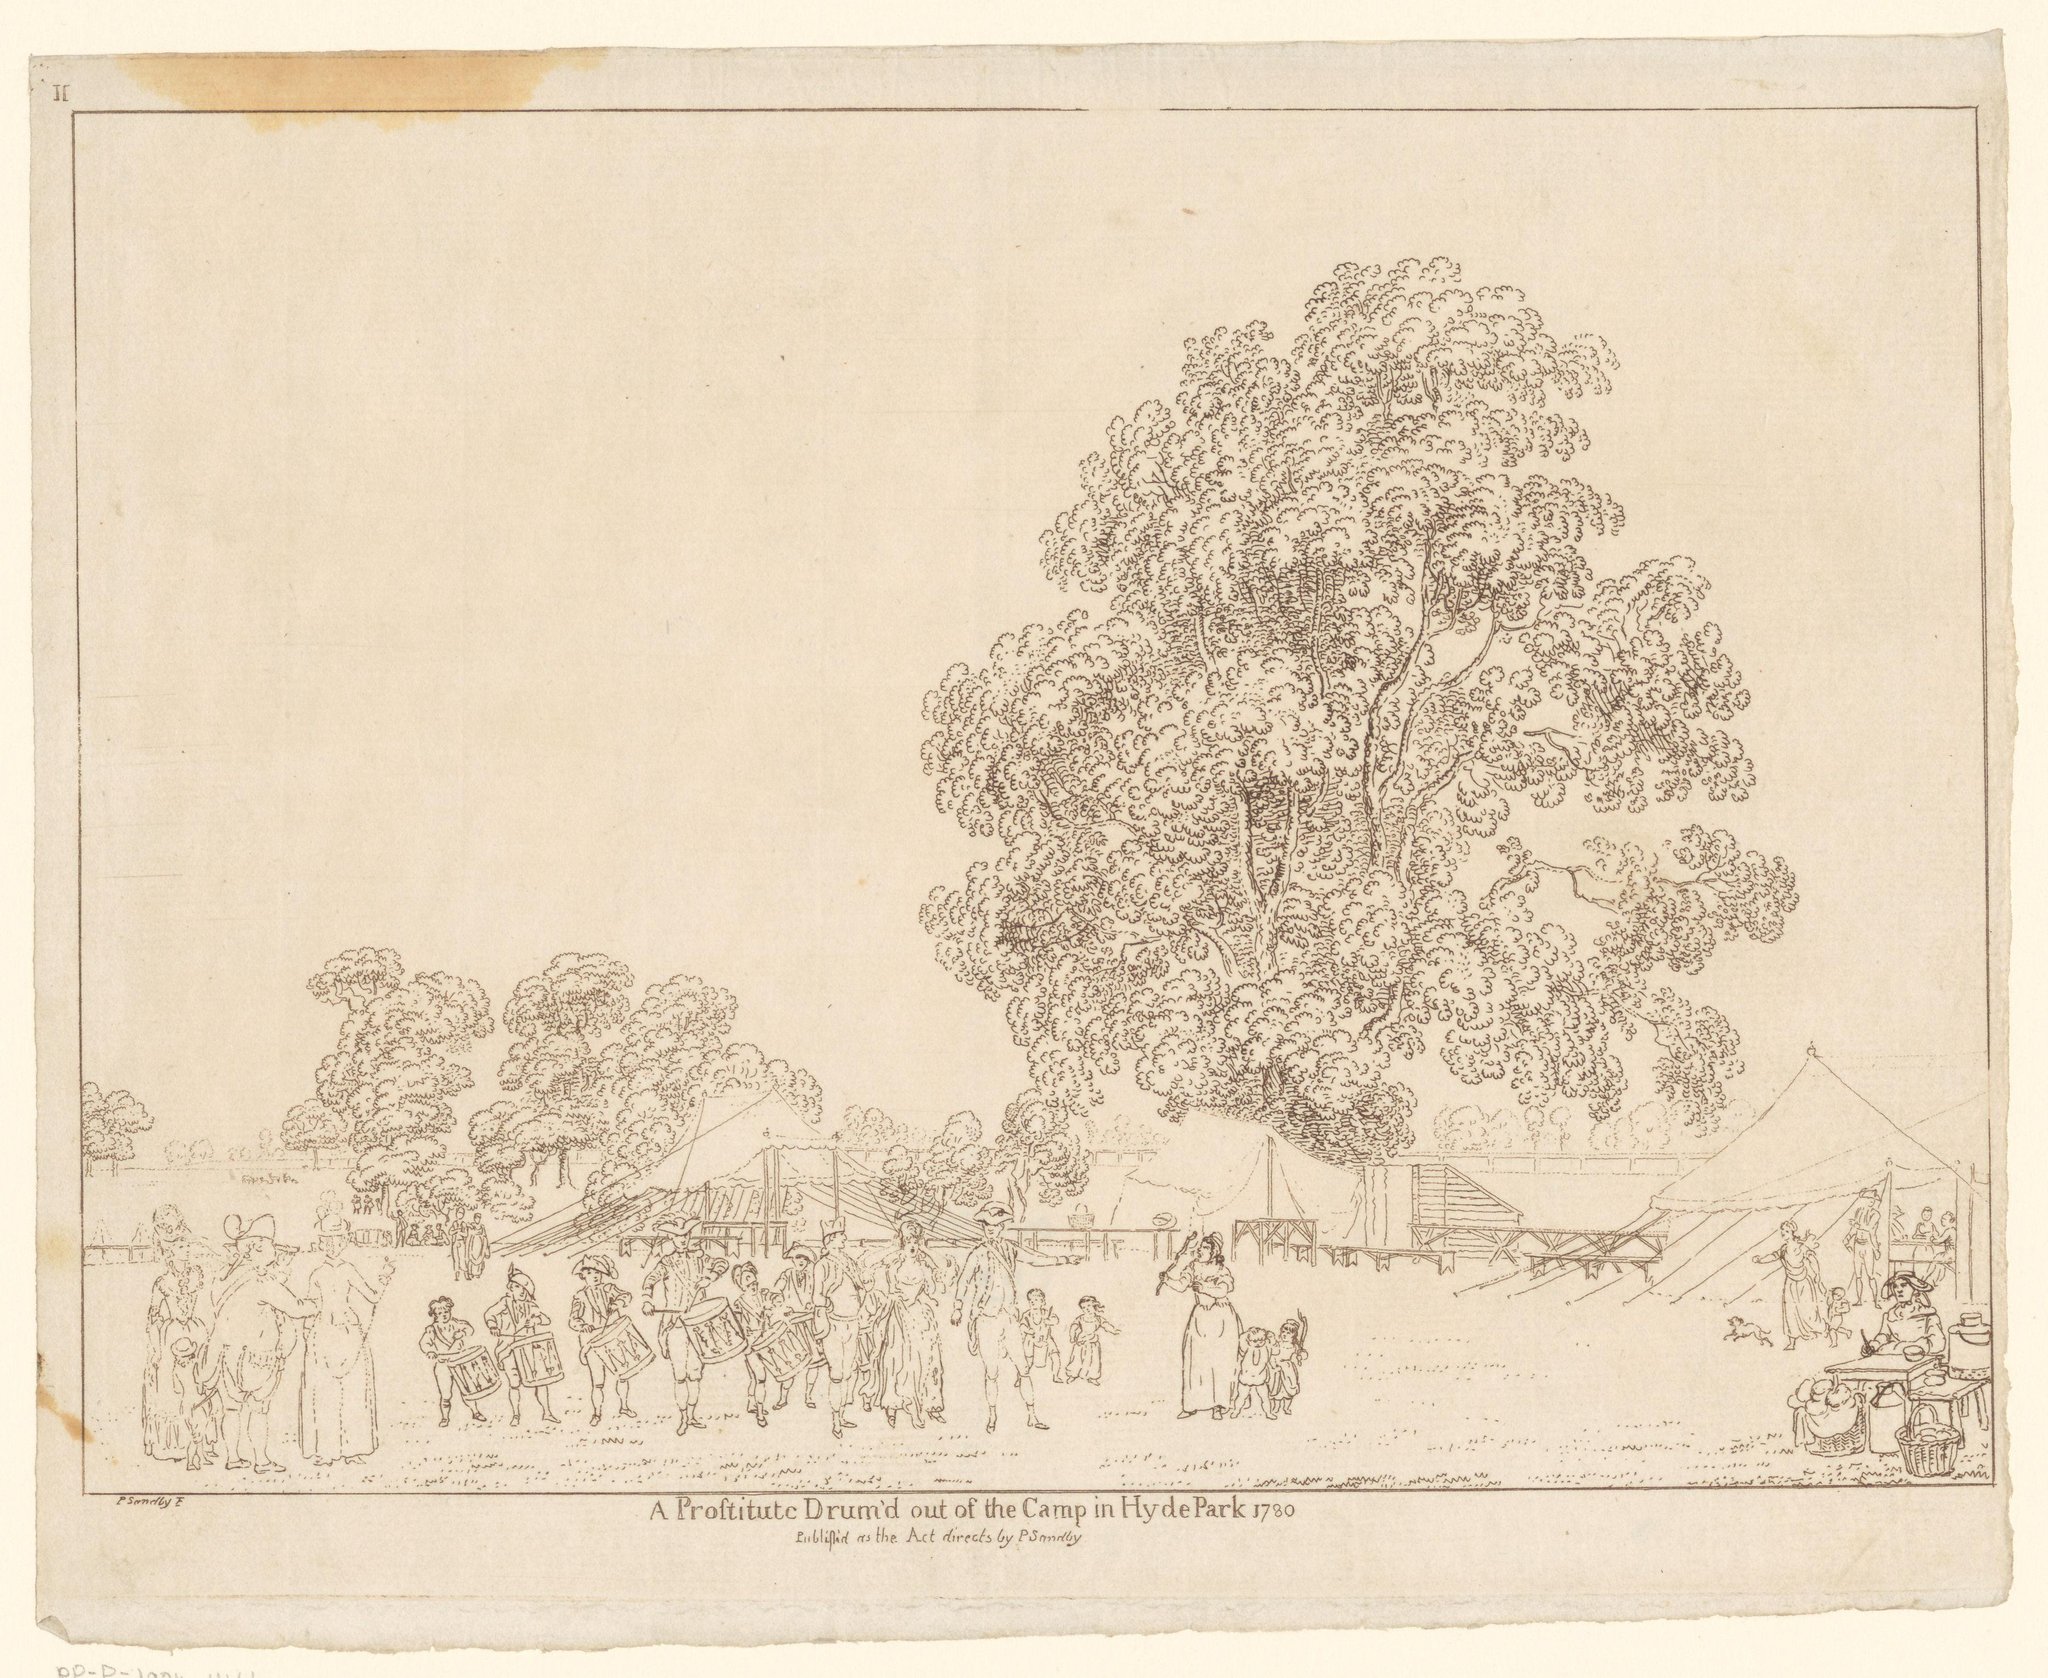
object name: print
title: Outline Views of Military Encampments, second set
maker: paul sandby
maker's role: draughtsman, print maker, publisher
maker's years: 1725-1809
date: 1780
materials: paper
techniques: etching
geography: london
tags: (military) camp with tents, public gardens, park (+ city(-scape) with figures, staffage)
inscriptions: collector's mark: Lugt 2228